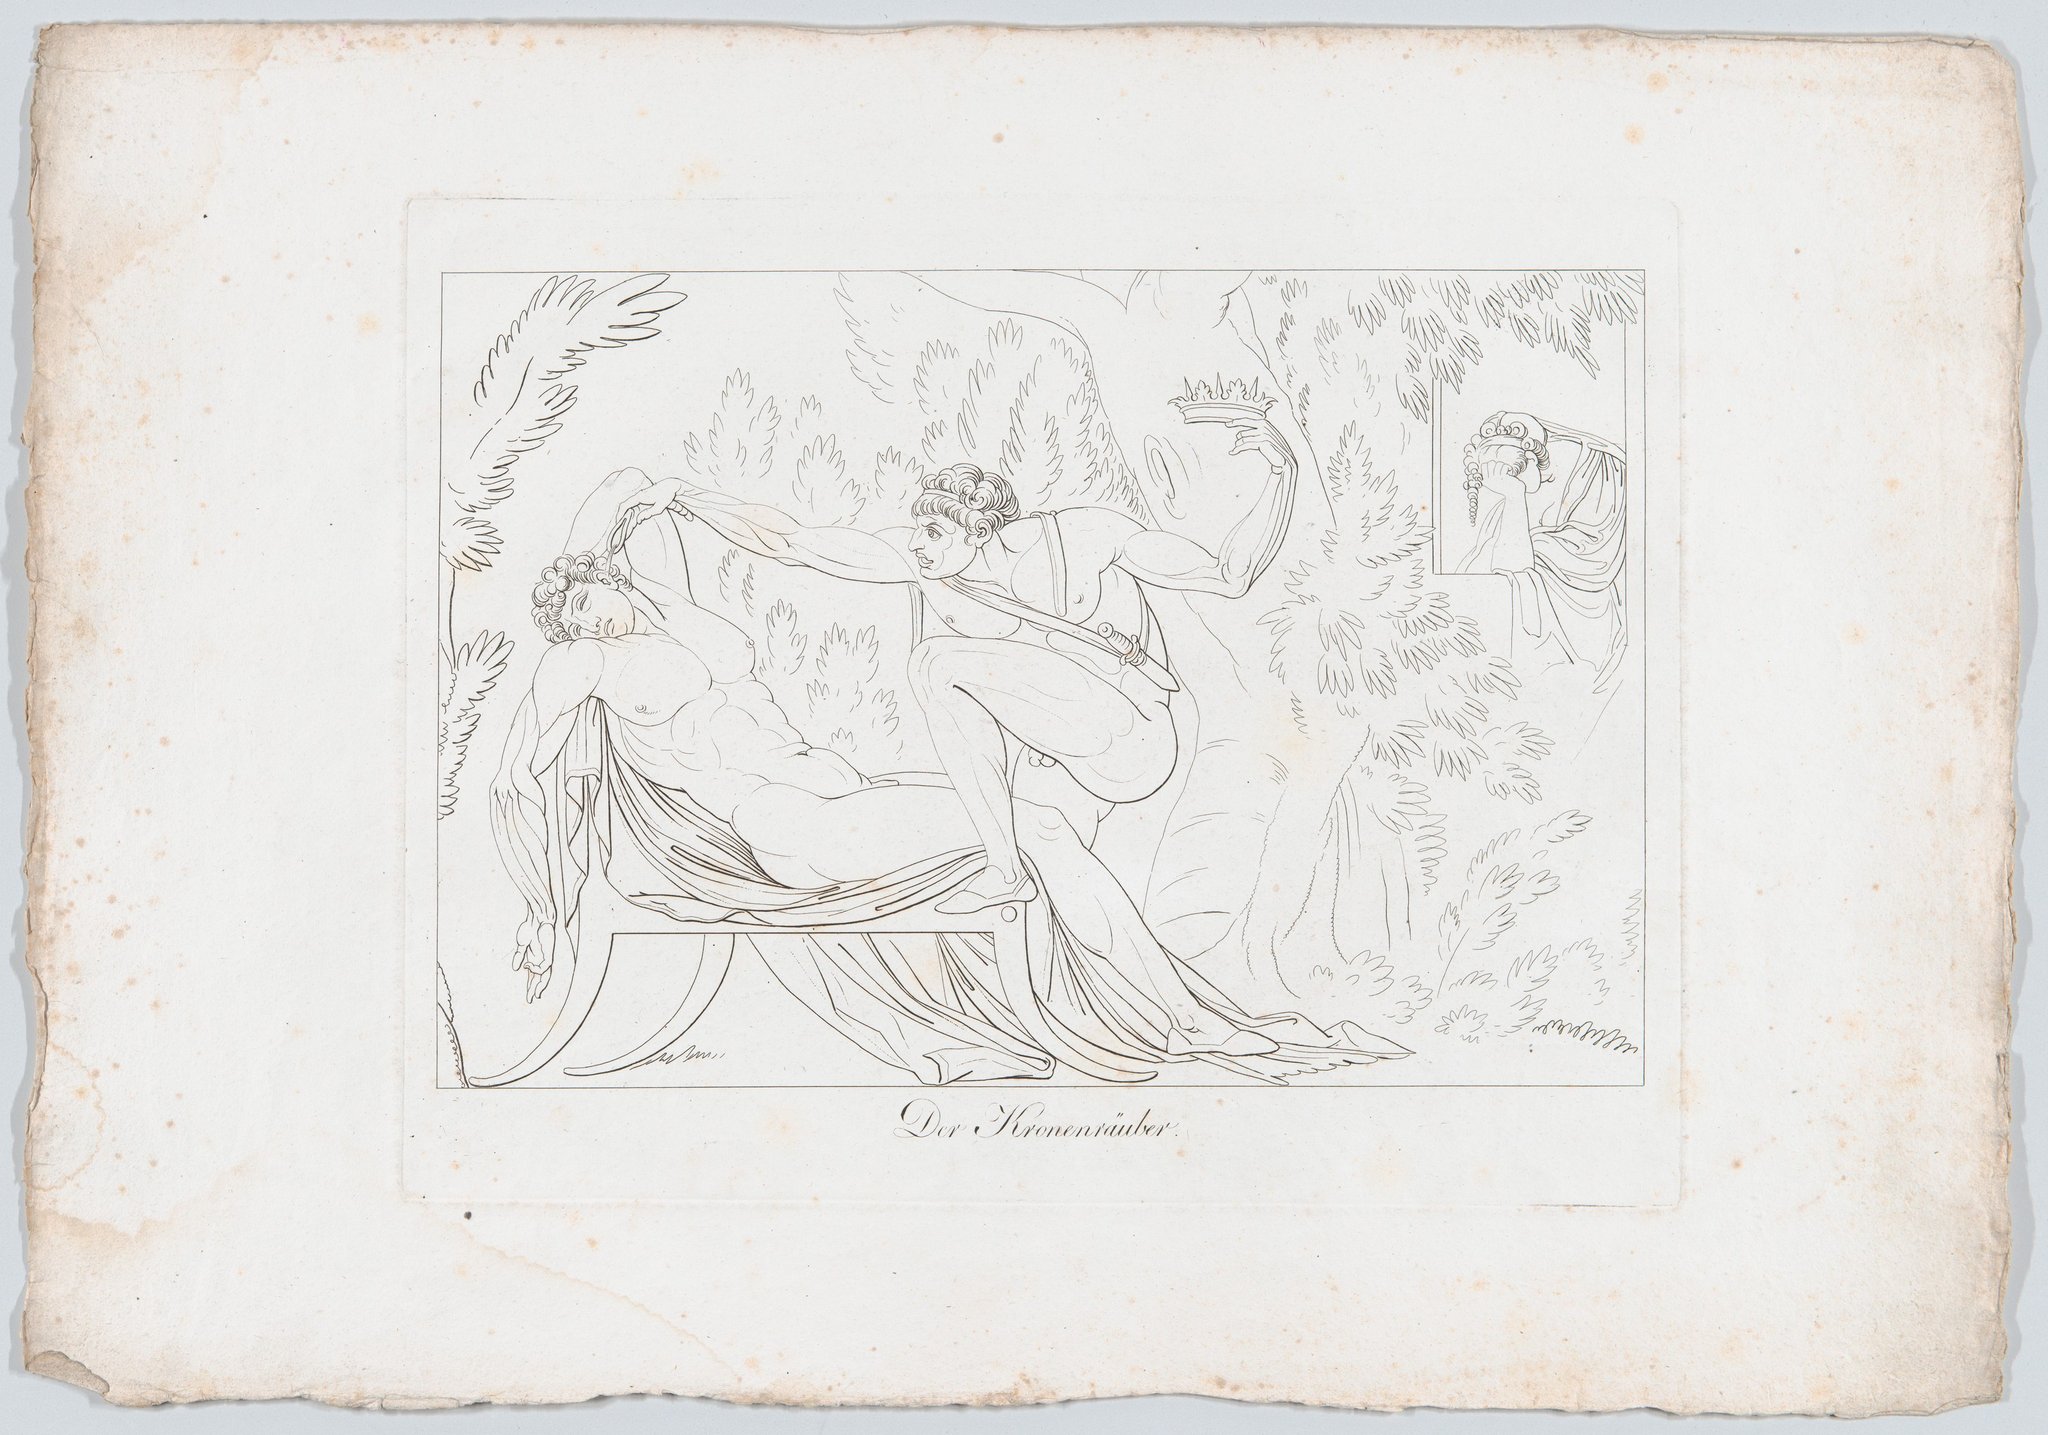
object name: print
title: Der Kronenräuber (Claudio Murders His Brother, King Hamlet, By Pouring Poison into His Ear as He Lies Sleeping in the Garden, Shakespeare, Hamlet, Act 1, Scene 5: 58-78)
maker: johann heinrich lips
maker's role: engraver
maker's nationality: swiss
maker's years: 1758-1817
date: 1806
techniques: engraving, etching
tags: shakespeare,male nudes,hamlet